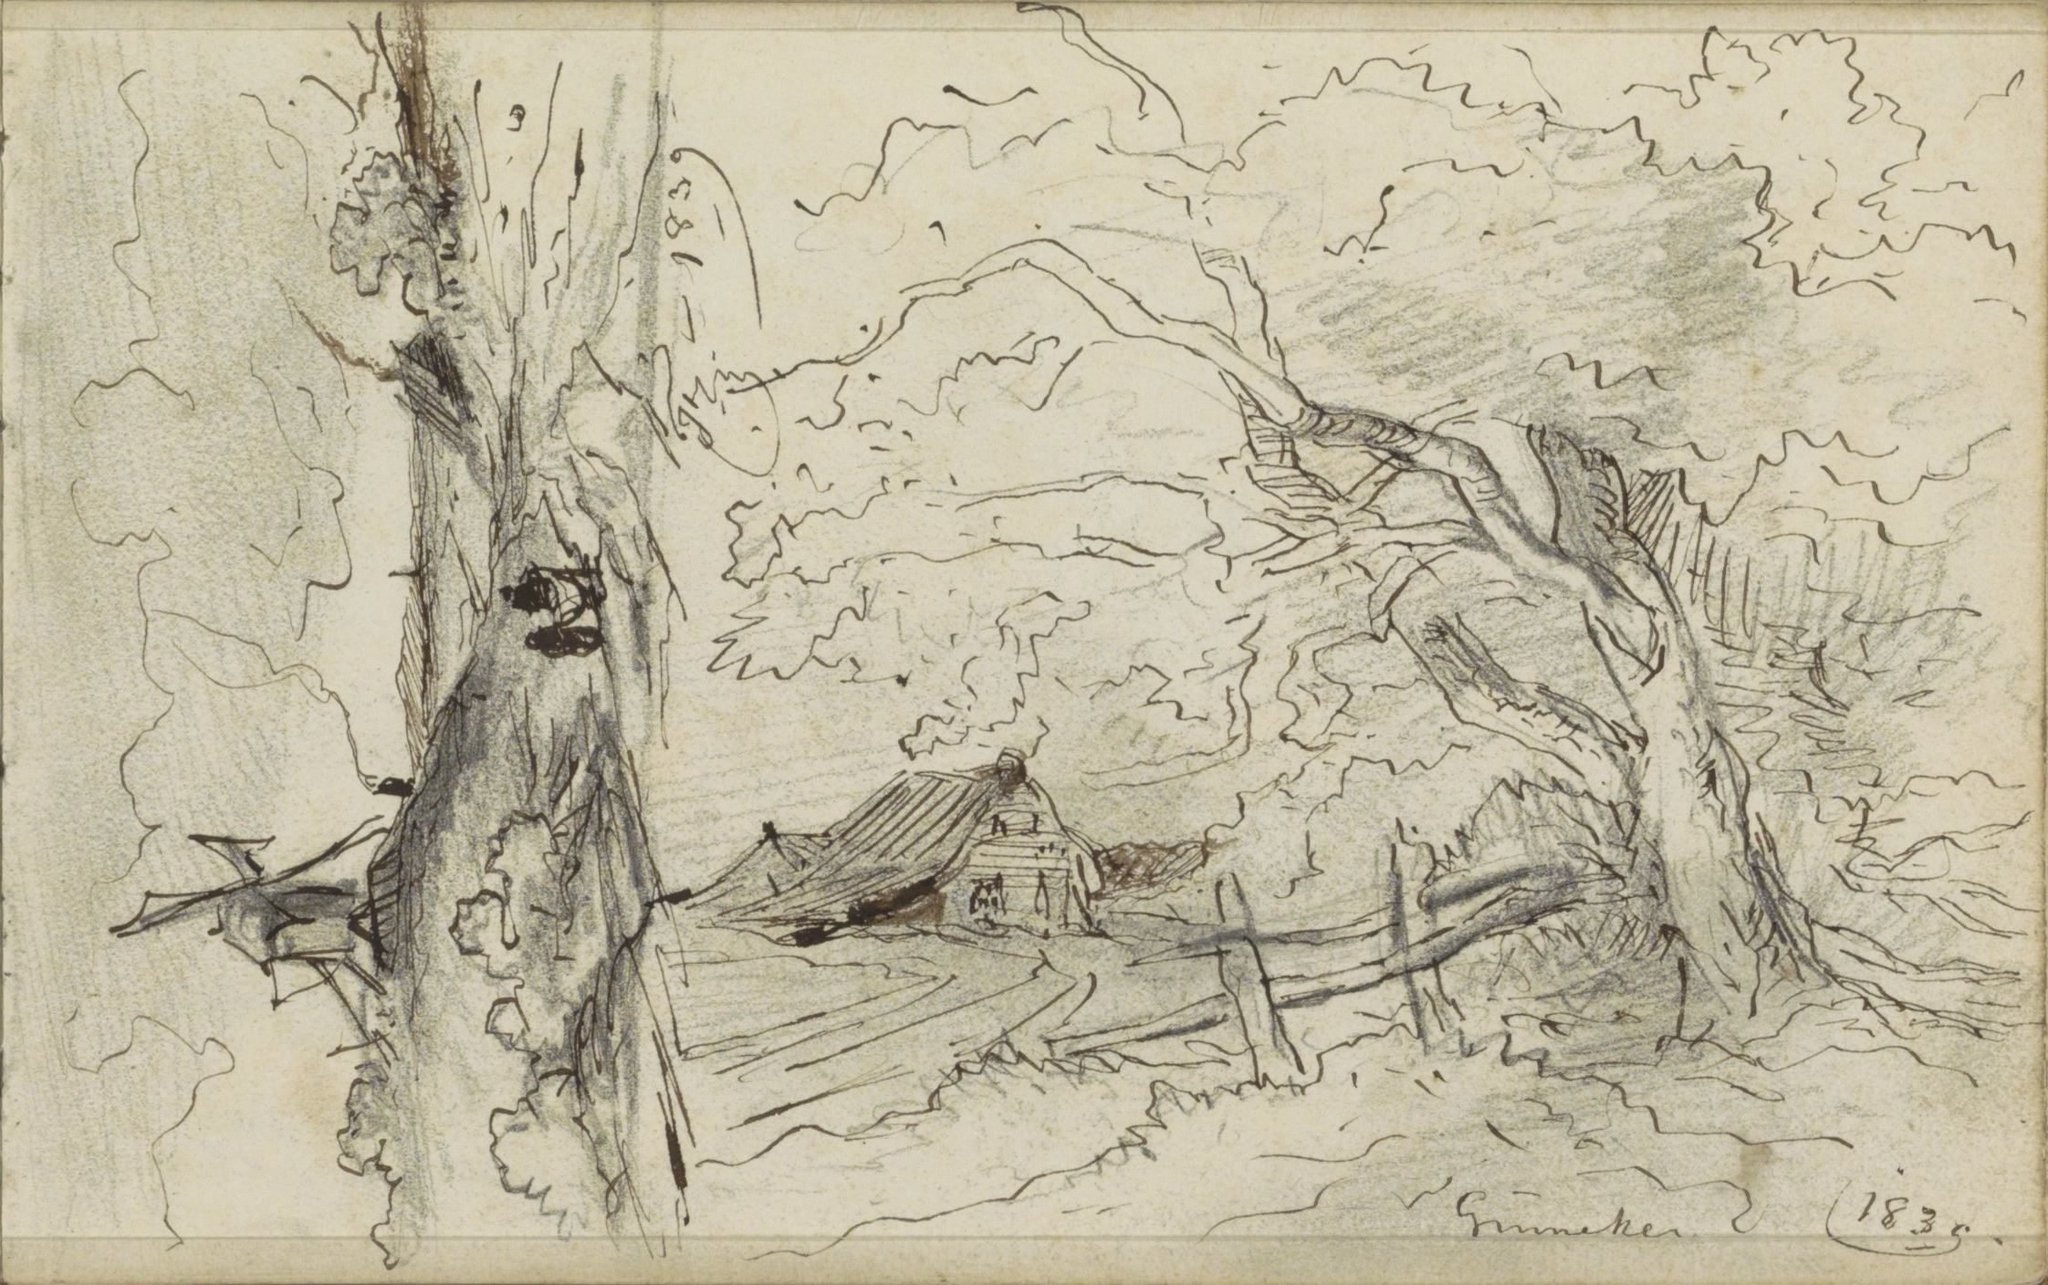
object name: sketchbook leaf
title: Landschappen in Ginneken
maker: johannes tavenraat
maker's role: draughtsman, painter, print maker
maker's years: 1809-1881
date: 1839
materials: paper, pencil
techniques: pen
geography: ginneken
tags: trees, housing, factories and mills in landscape, road, path, landscapes (+ landscape with figures, staffage)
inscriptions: date and inscription: ‘Ginneken 1839.’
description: Met een molen en een landschap met een huis. Blad 28 recto uit een schetsboek met 37 bladen.